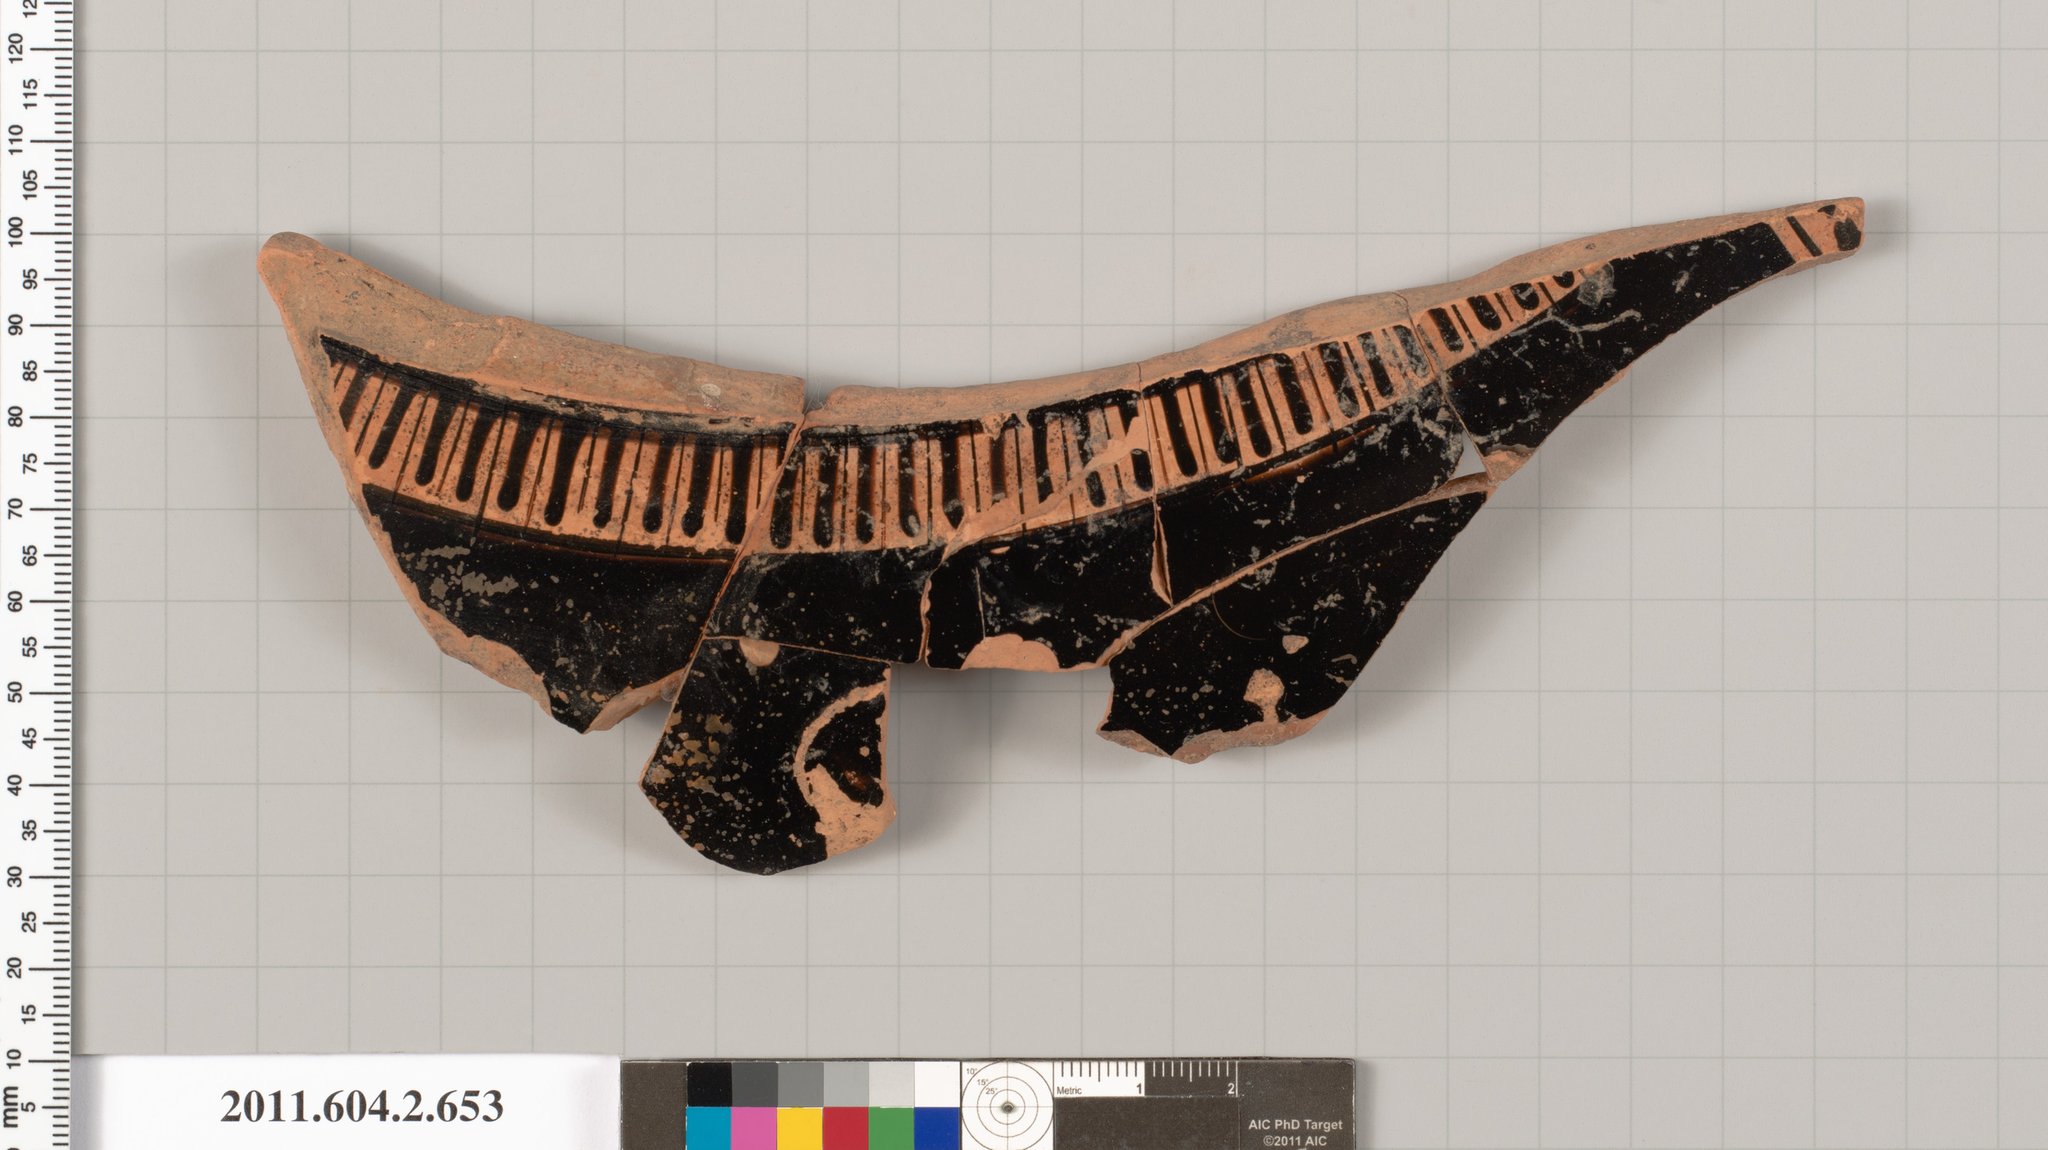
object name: stamnos or column krater fragment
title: Terracotta fragment of a stamnos (jar) or a column-krater (bowl for mixing wine and water)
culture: greek, attic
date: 475-451 BCE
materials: terracotta